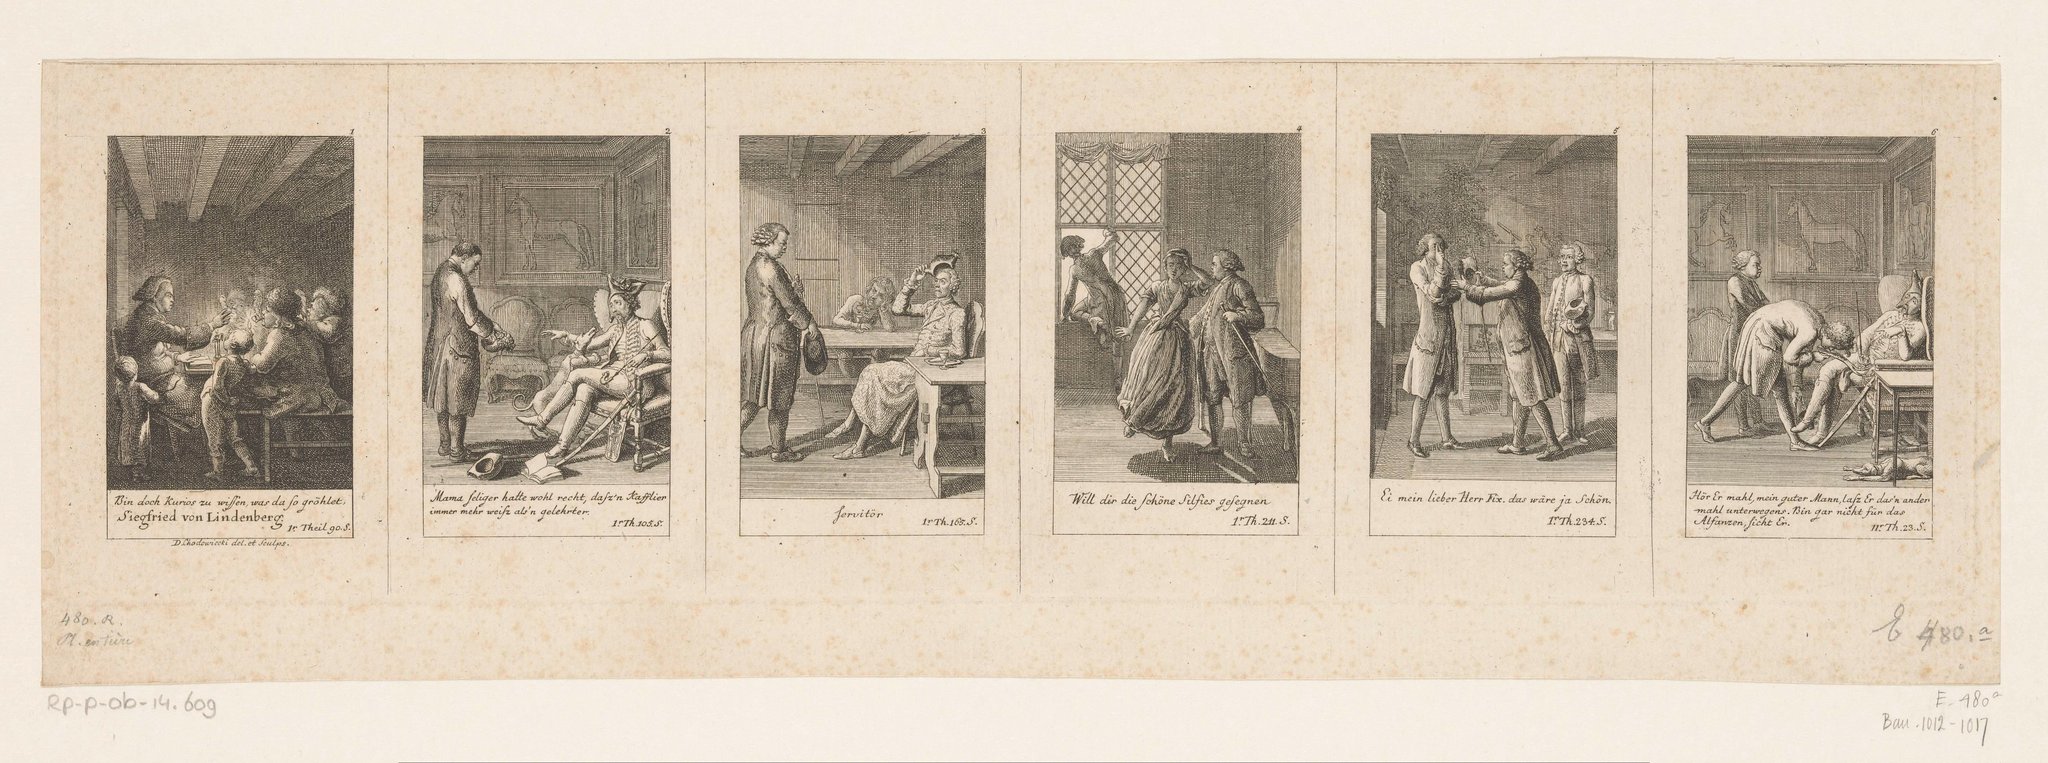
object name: book illustration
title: Zes voorstellingen uit Müller's Siegfried von Lindenberg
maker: daniel nikolaus chodowiecki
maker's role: draughtsman, print maker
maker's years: 1726-1801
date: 1783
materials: paper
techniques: etching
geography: berlin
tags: introducing, literature, teacher and pupil, flight, running away; pursuing, interior of the house, wig, open window, conversation, dialogue; conversation piece, index finger forwards, pointing, indicating, dog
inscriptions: collector's mark: Lugt 2228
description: Zes voorstellingen op één plaat. Vervaardigd voor J. G. Müller's 'Siegfried von Lindenberg'. Een latere staat gebruikt in: Goettinger Taschen Calender vom Jahr 1784. bey Joh. Chr. Dietrich. Göttingen: Georg Christoph Lichtenberg, 1784.